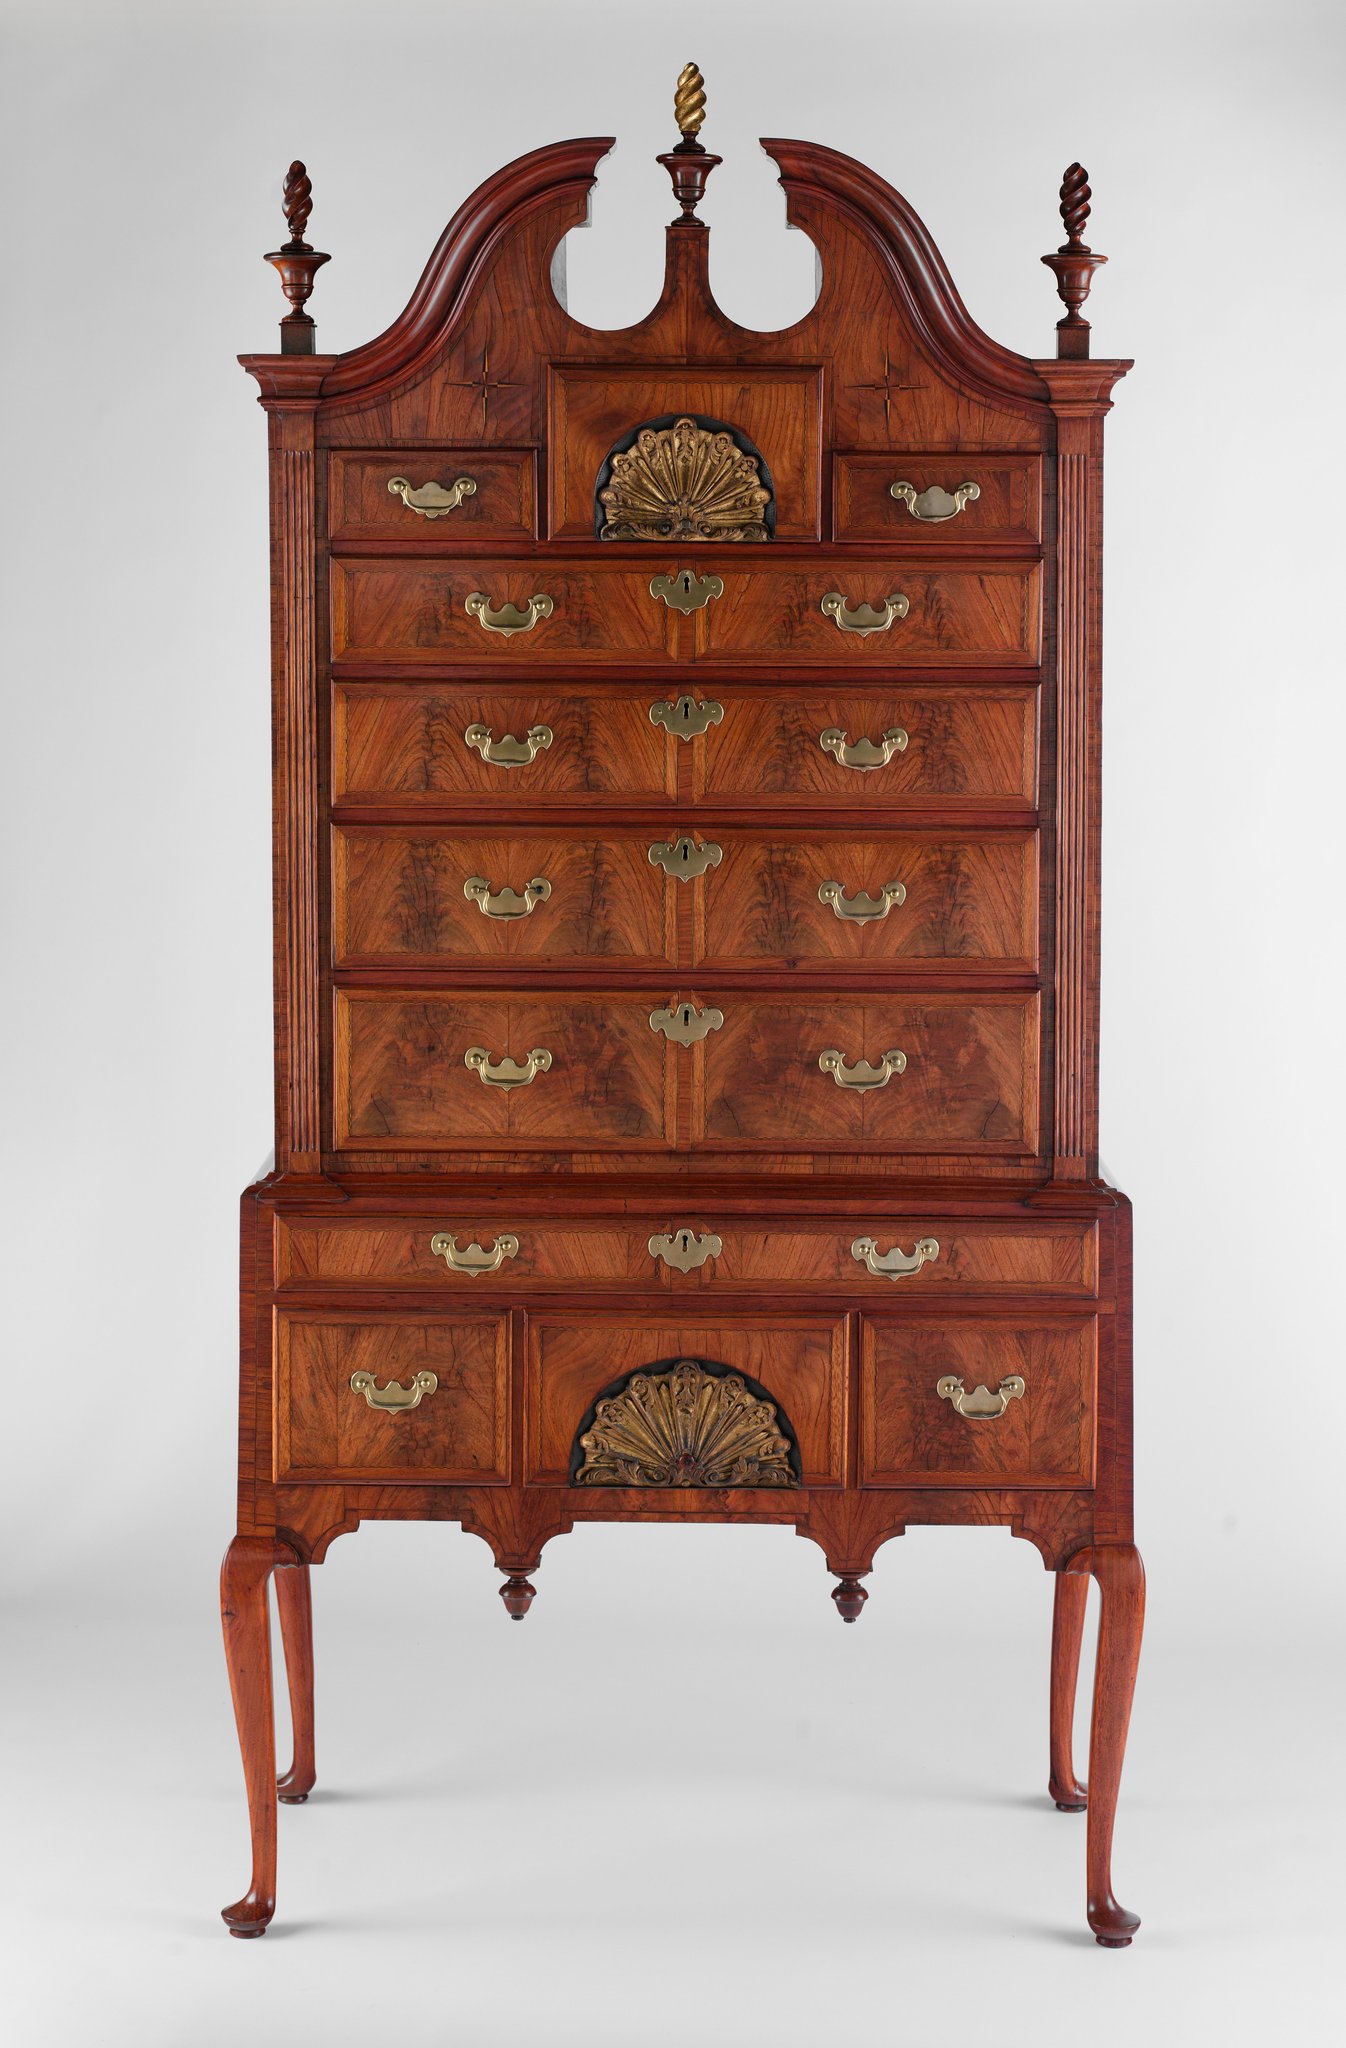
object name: high chest of drawer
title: High Chest of Drawers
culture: american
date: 1730-1740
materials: brass, wood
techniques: veneering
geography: united states